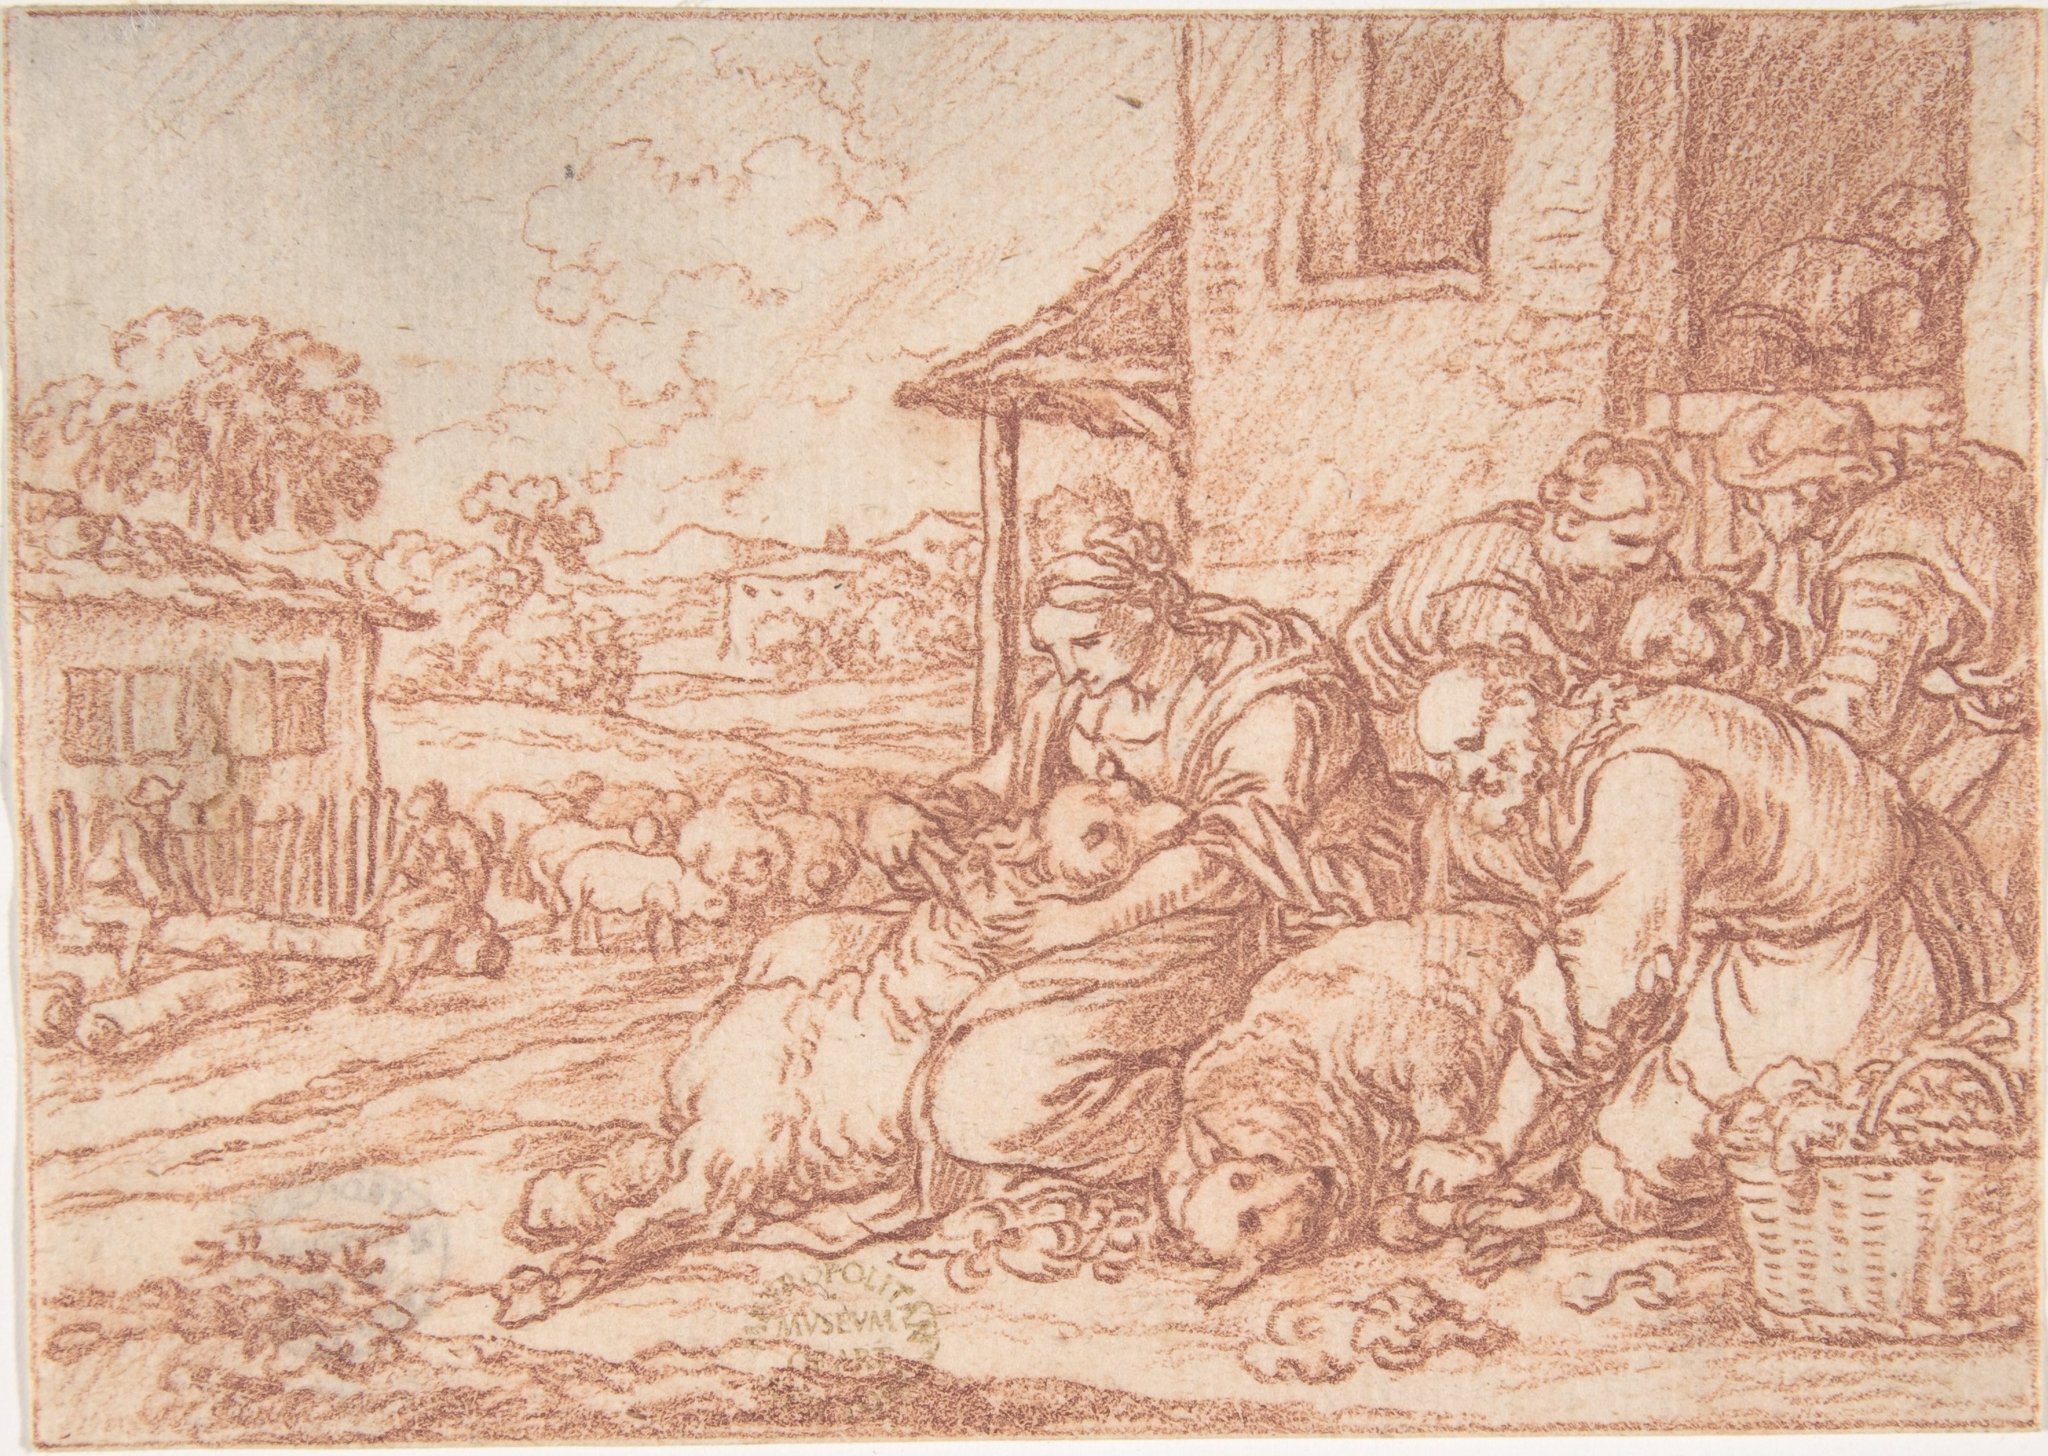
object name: drawing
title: June (one of a series representing the labors of the months)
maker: jonas umbach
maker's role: artist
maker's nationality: german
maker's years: 1624-1693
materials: chalk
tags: animals,men,women